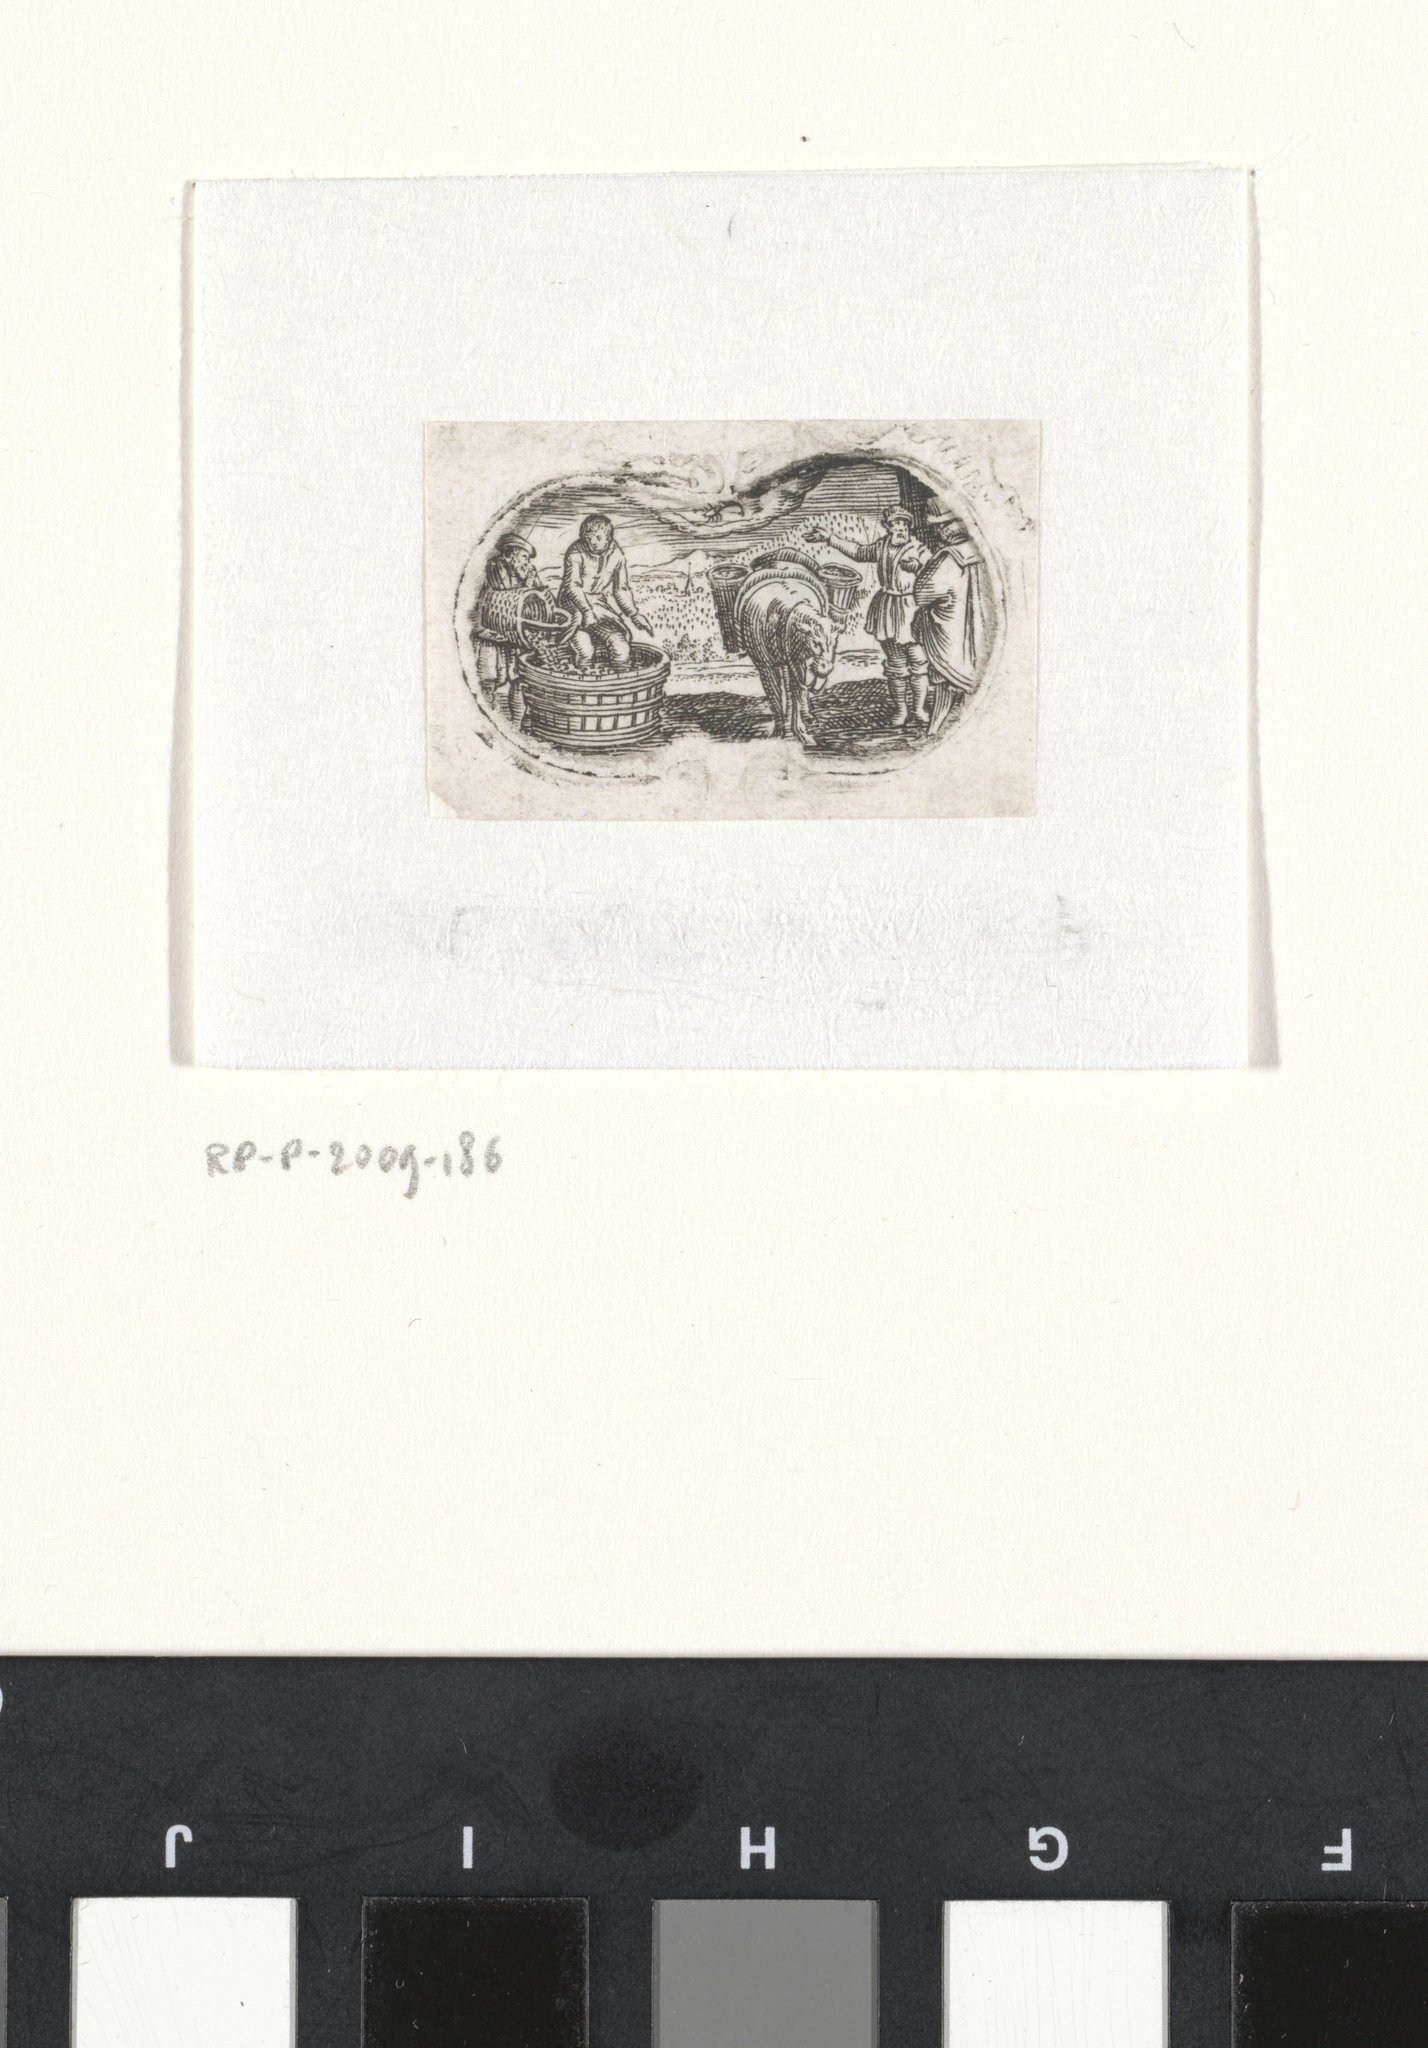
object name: print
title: De twaalf maanden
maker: Anonymous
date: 1625-1700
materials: paper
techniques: engraving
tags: october and its 'labours', scorpio (zodiacal sign of october), vintage, grape harvest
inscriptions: collector's mark: Lugt 2228, collector's mark: Lugt 2760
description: Menselijke bezigheden in de maand oktober. Links twee figuren waarvan één bezig met het stampen van druiven. In het midden een ezel en rechts daarvan twee figuren. Middenboven het sterrenbeeld Schorpioen.